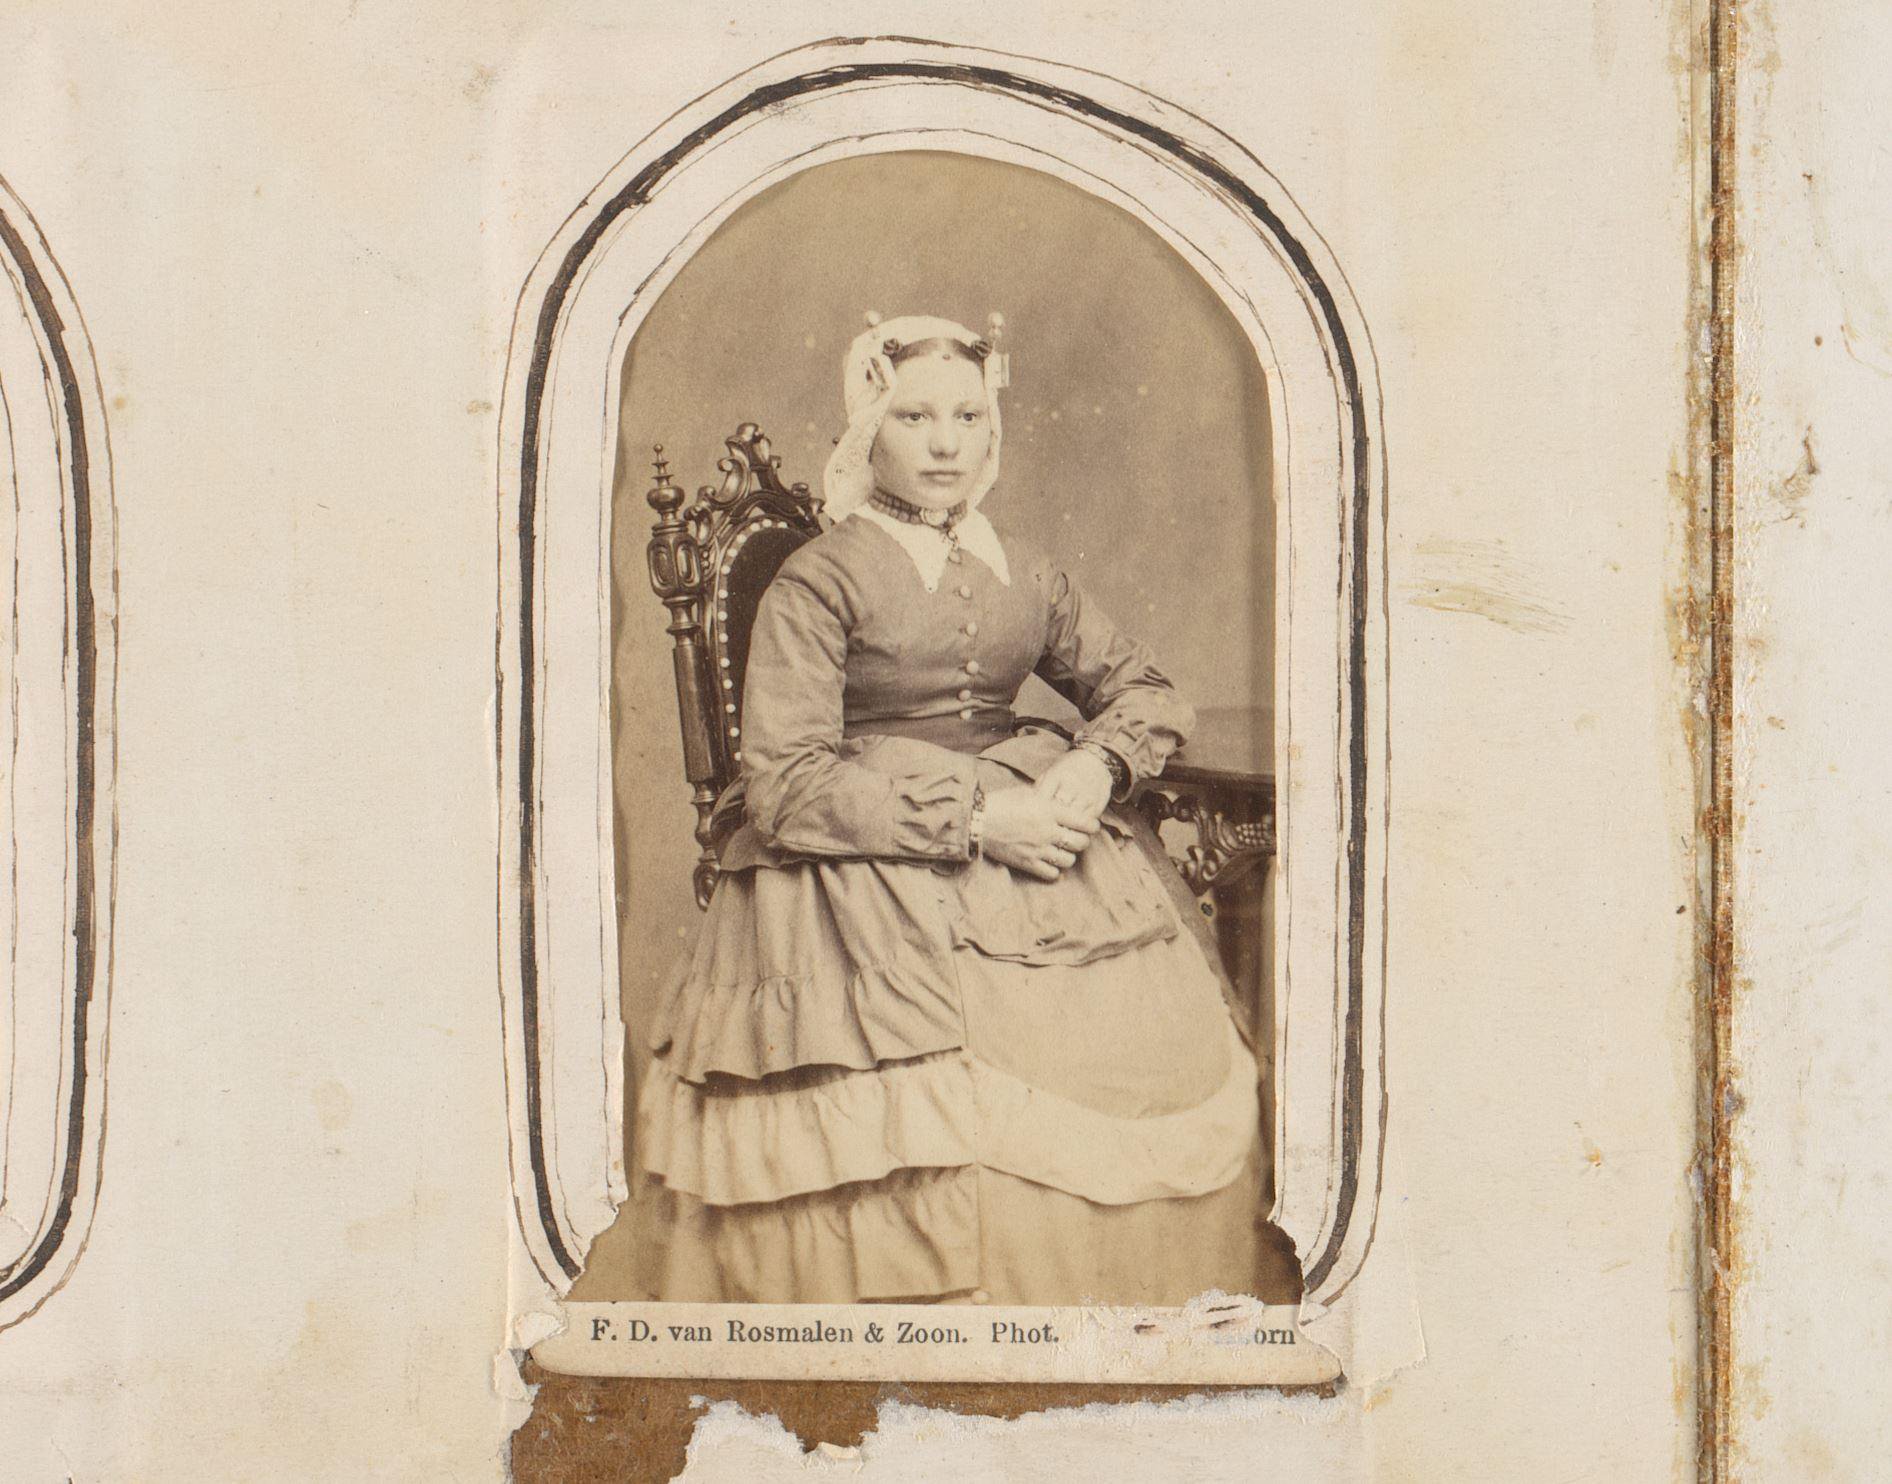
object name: photograph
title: Portret van een zittend meisje met witte klederdrachtmuts en oorijzers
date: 1860-1880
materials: cardboard, photographic support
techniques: albumen print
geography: hoorn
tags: sitting figure - aa - female human figure, historical persons - bb - woman, girl (child between toddler and youth), head-gear: cap, folk costume, regional costume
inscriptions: inscription: ‘Photographie/ F.D. VAN ROSMALEN & ZOON/ NIEUWESTEEG/ HOORN.’